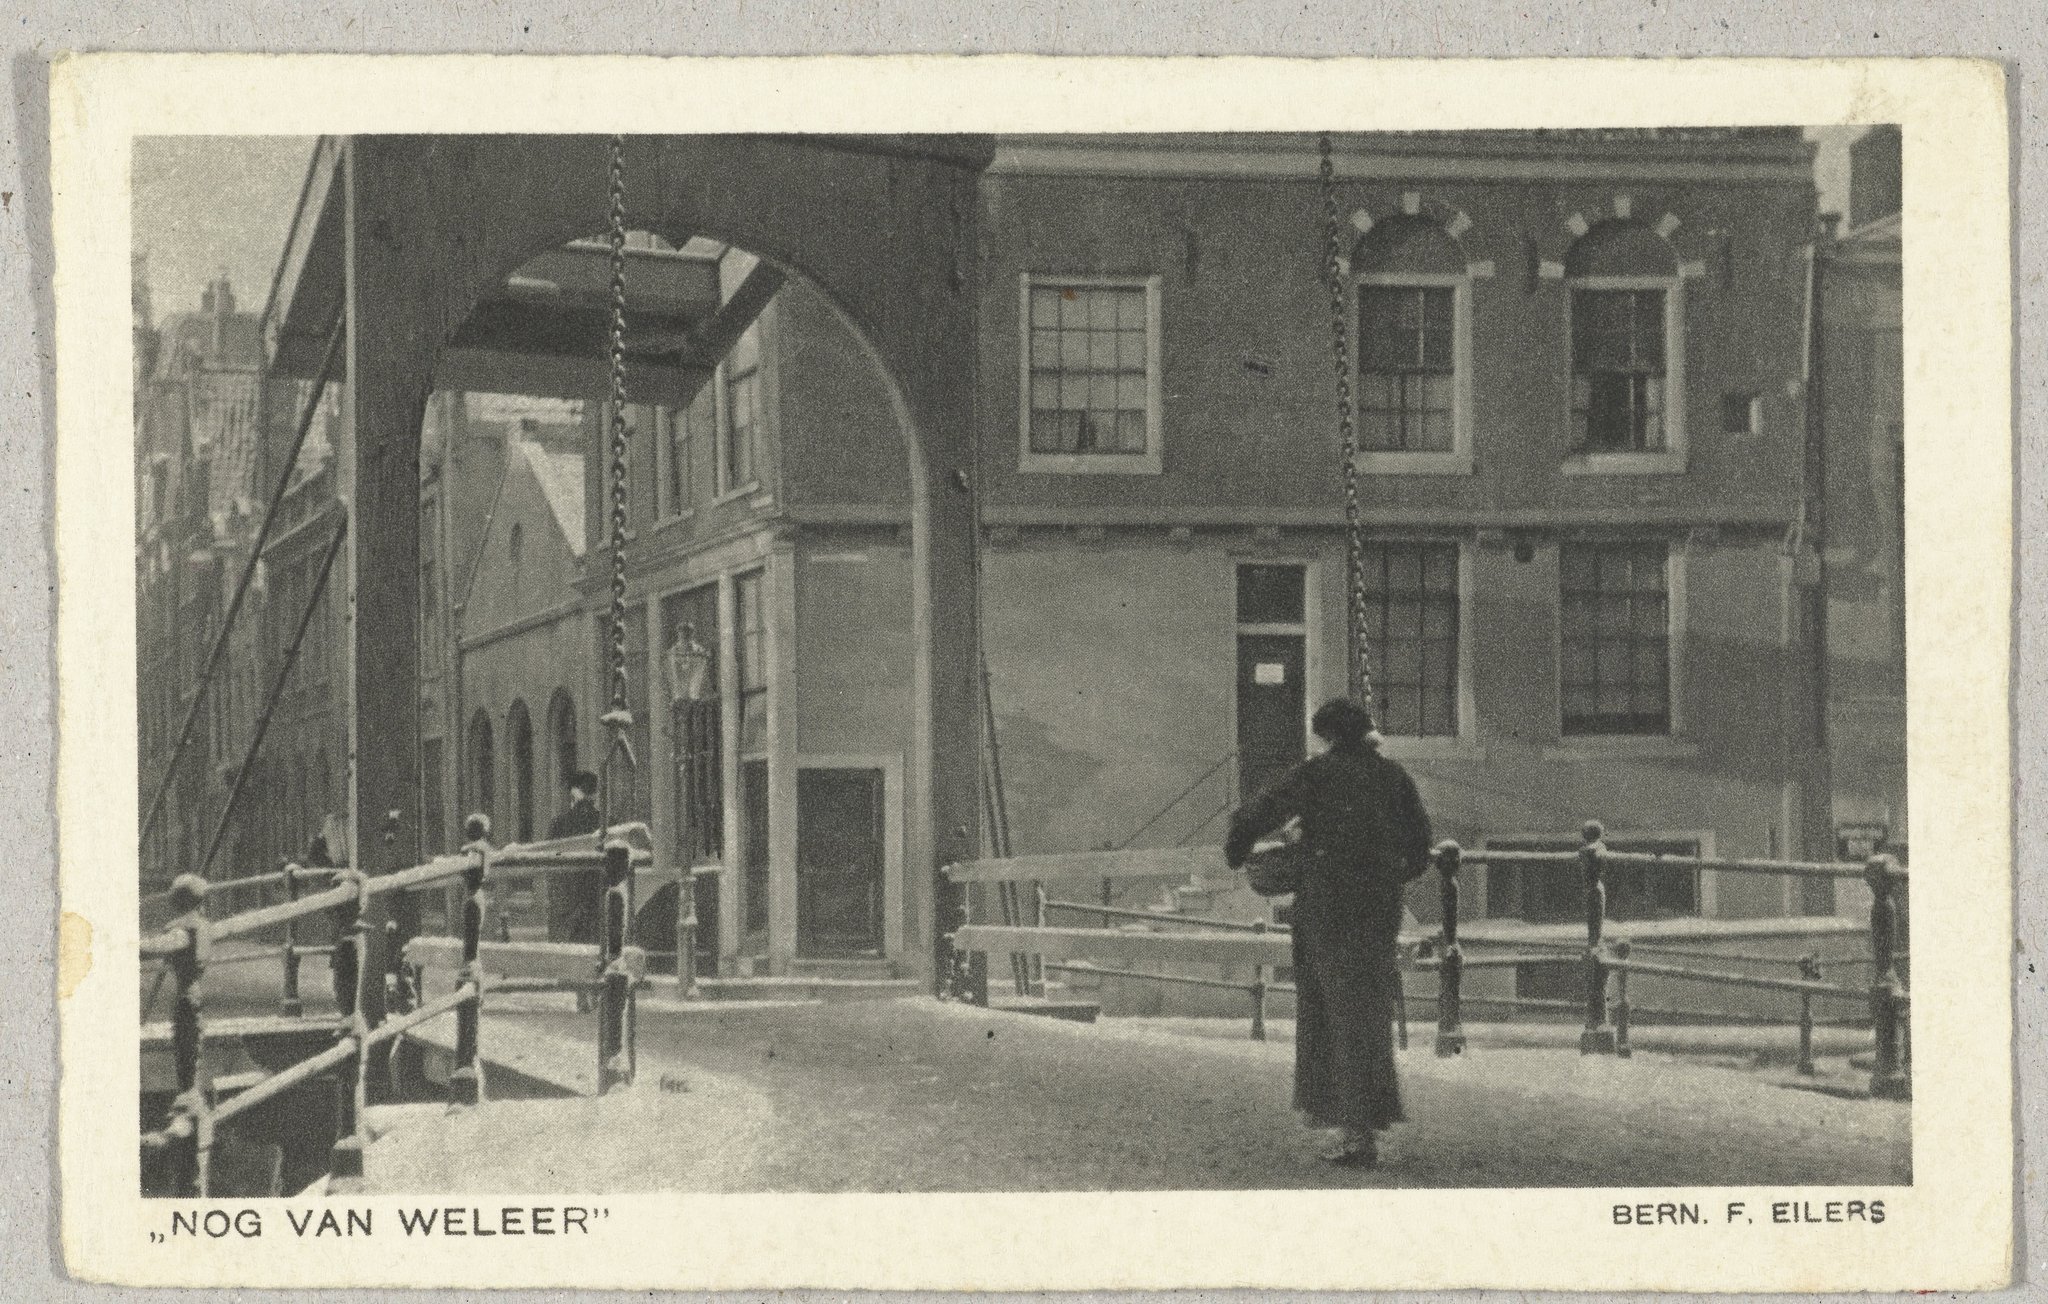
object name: photograph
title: Brug in de Staalstraat bij de Groenburgwal in Amsterdam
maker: bernard eilers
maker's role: fotograaf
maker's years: 1878-1951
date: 1913-1940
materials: paper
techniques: rotogravure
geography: amsterdam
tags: bridge in city across river, canal, etc.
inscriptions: name: ‘Bern. F. Eilers’, annotation: ‘Eilers Artistieke kaarten - uitg.-mij. "Kosmos" - Amsterdam’, annotation: ‘serie: A, Amsterdam, Staalstraat hoek Groenburgwal "Nog van weleer"’